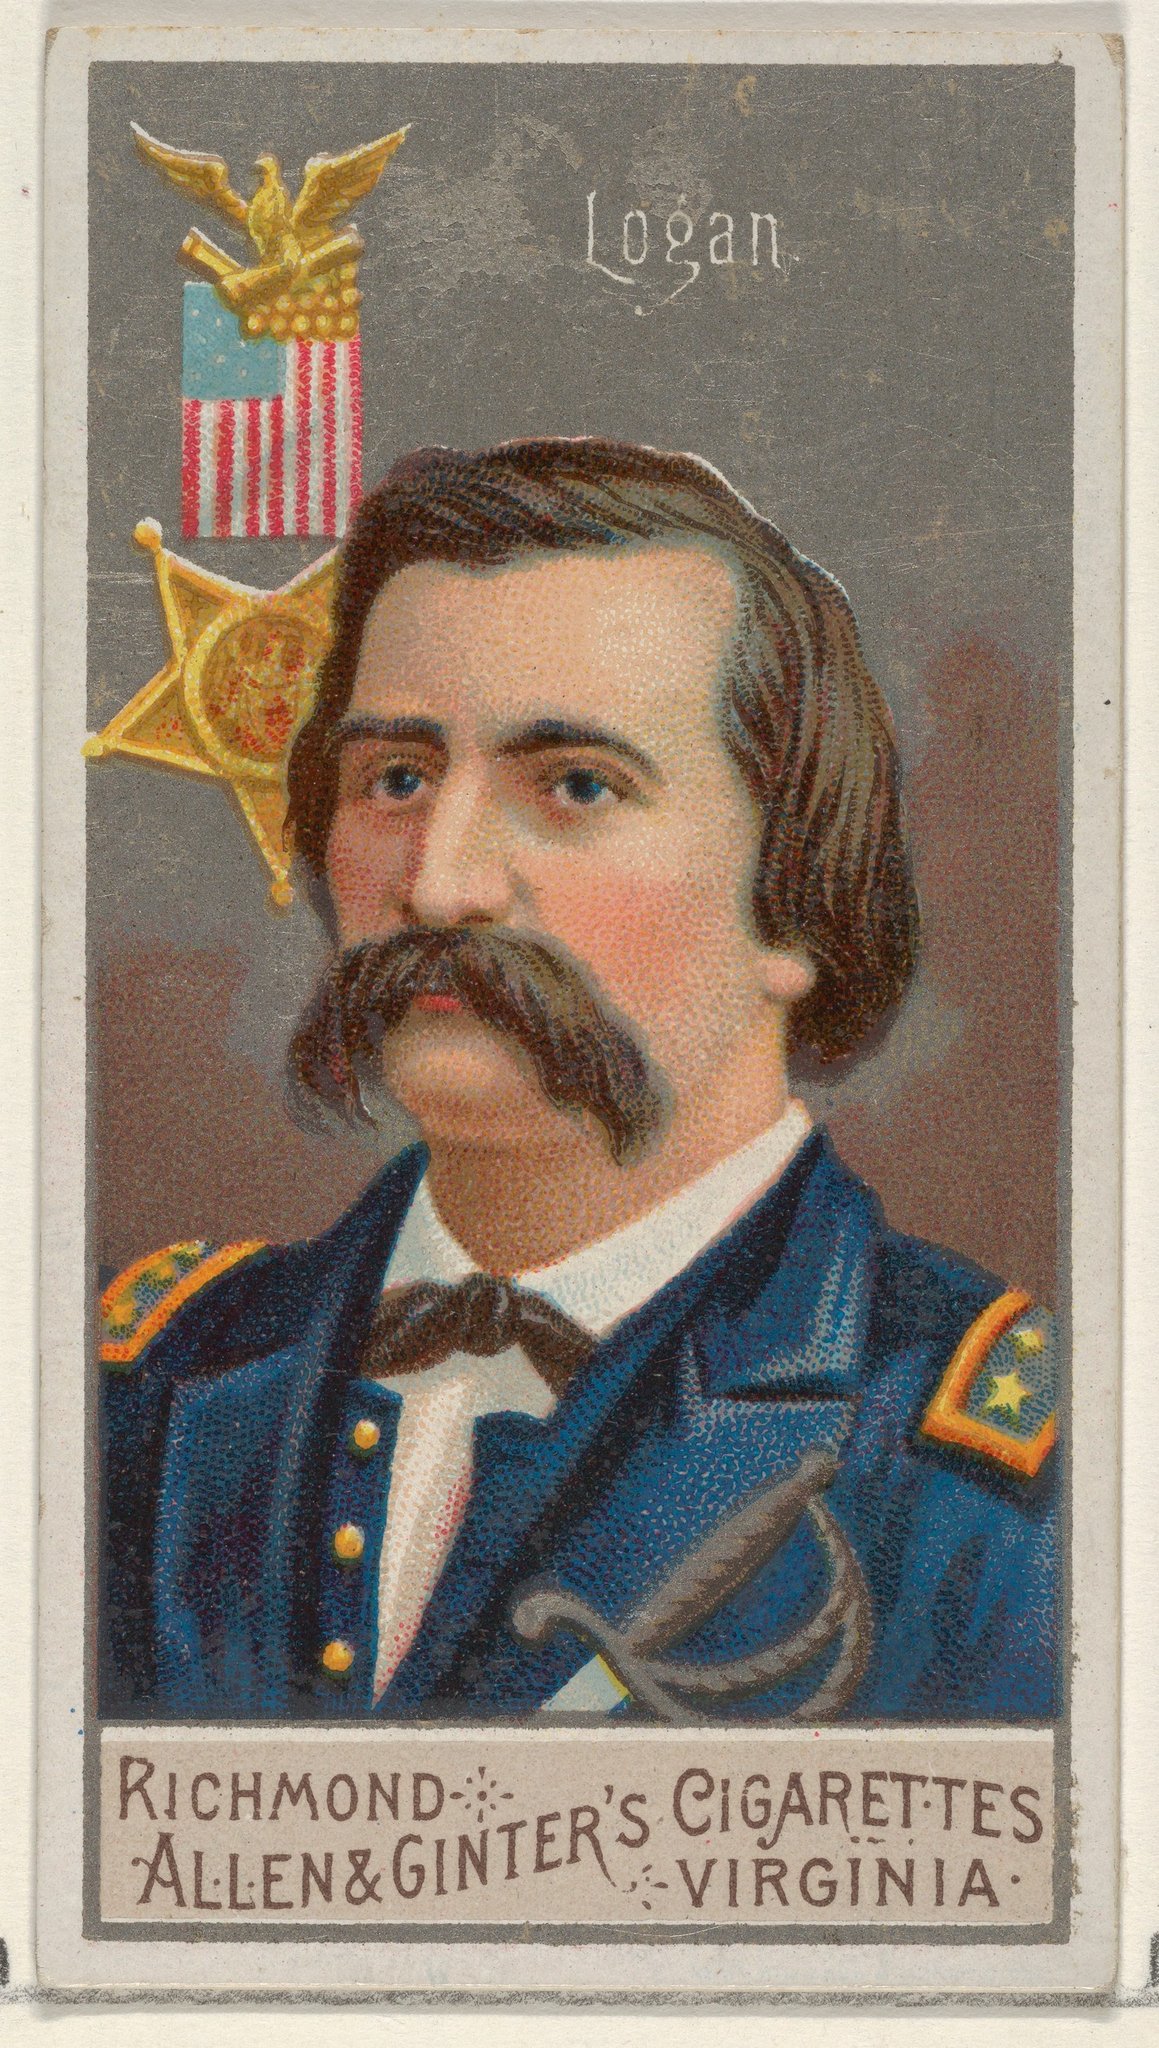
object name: print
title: John Alexander Logan, from the Great Generals series (N15) for Allen & Ginter Cigarettes Brands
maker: allen & ginter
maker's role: publisher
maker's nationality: american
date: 1888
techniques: color lithograph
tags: men,generals